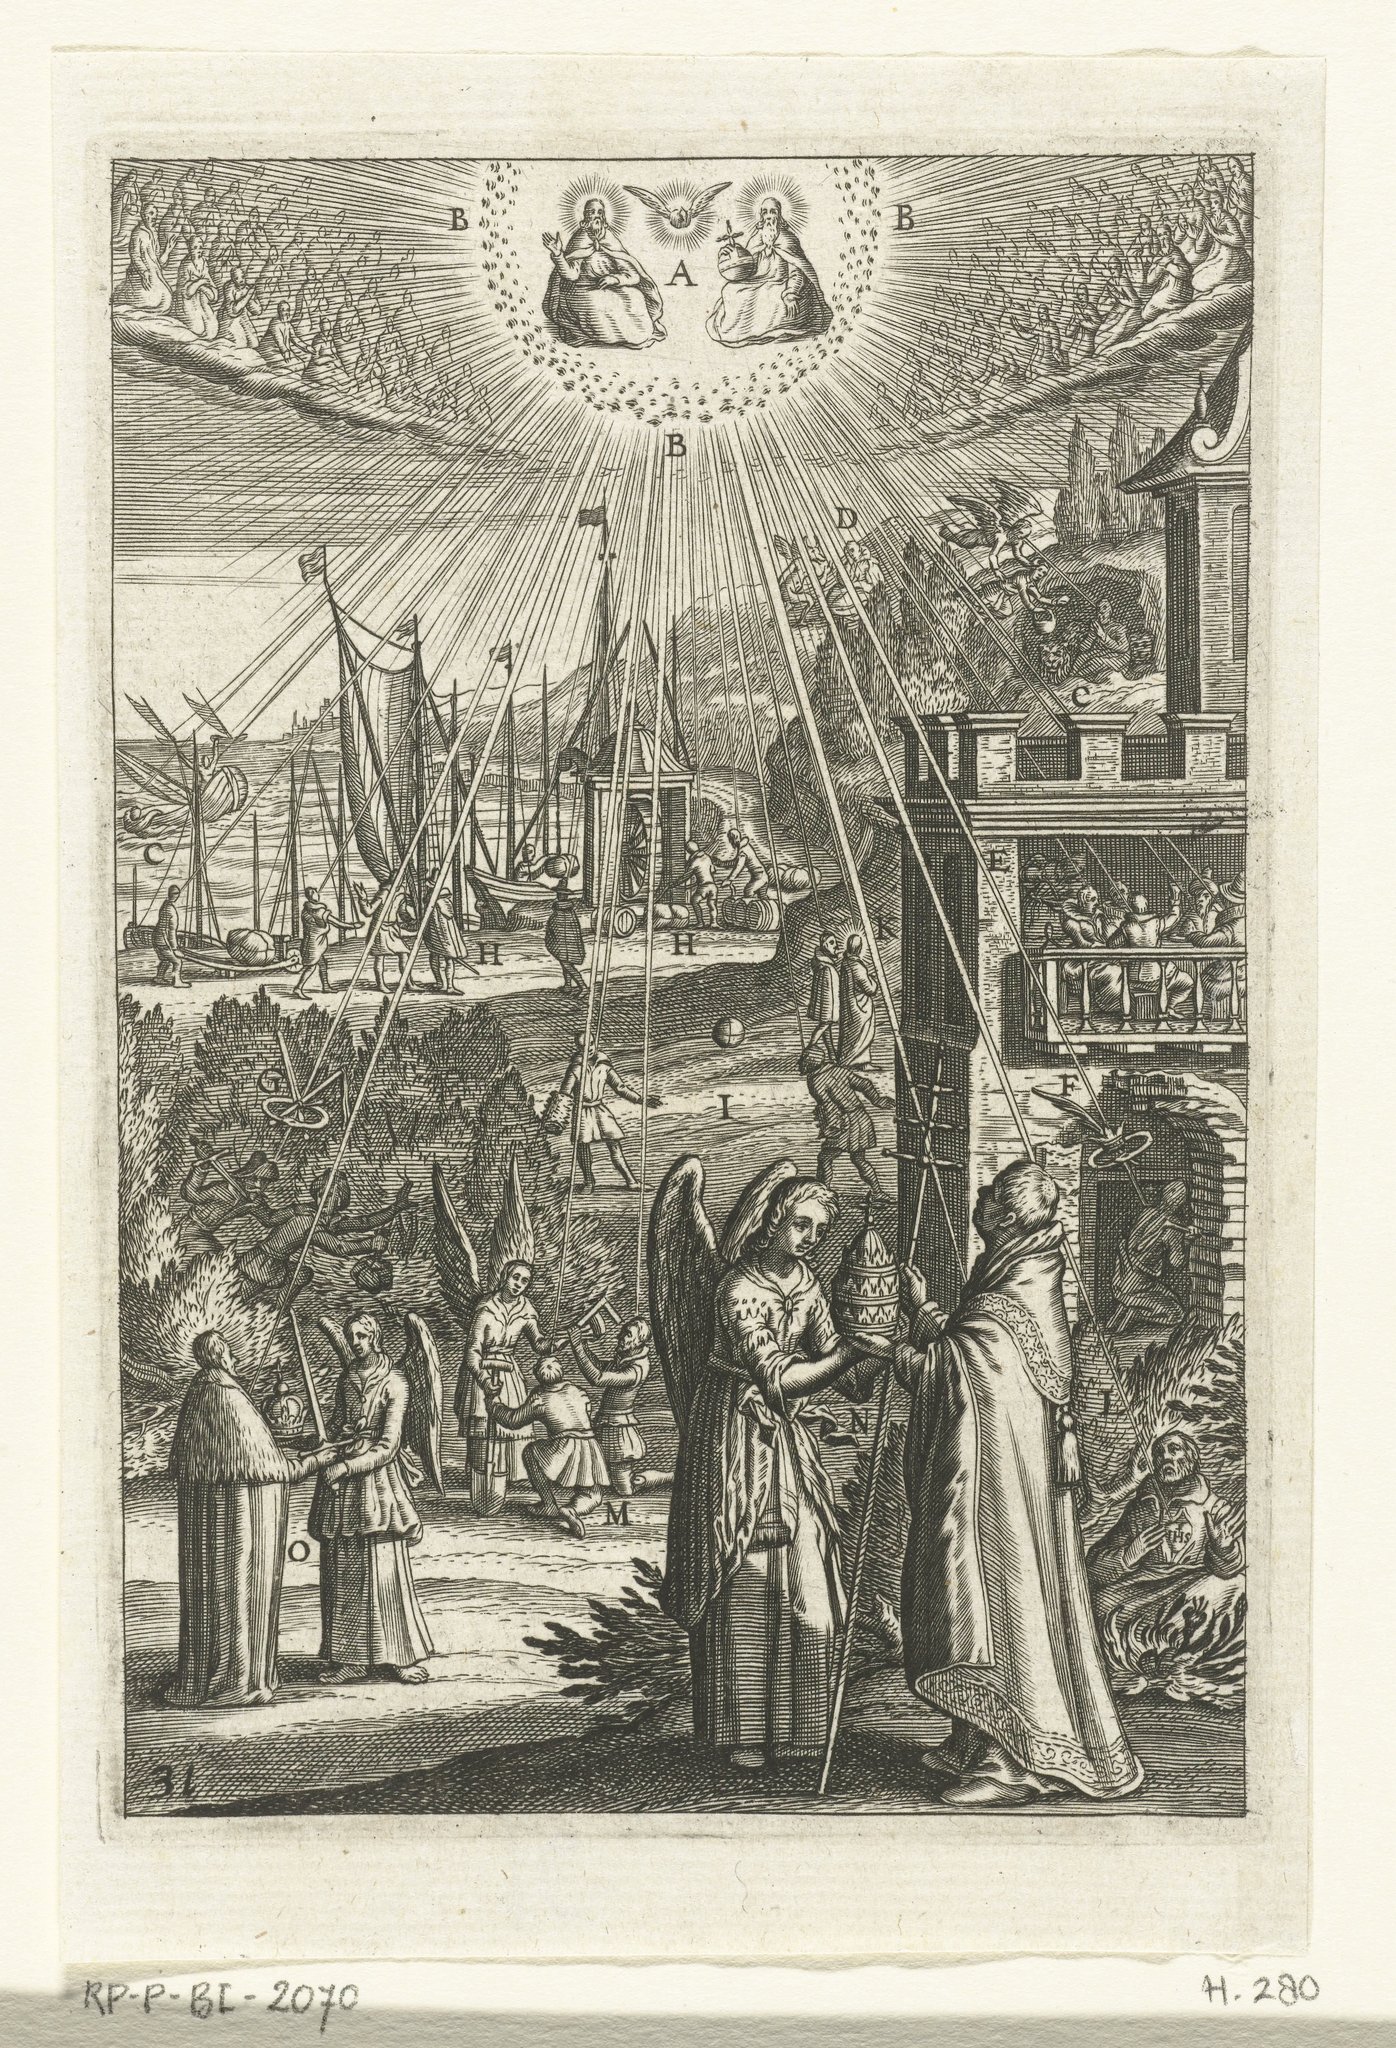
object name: book illustration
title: Den wech des eeuwich levens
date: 1620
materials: paper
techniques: engraving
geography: antwerp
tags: the worship of god, the life of man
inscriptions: collector's mark: Lugt 2228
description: Prent uit: Antoine Sucquet, Den wech des eeuwich levens, beschreven int latijn : met beelden verlicht door Boëtius a Bolsvert, Antwerpen, Hendrick Aertssens, 1620, afb. tegenover p. 682